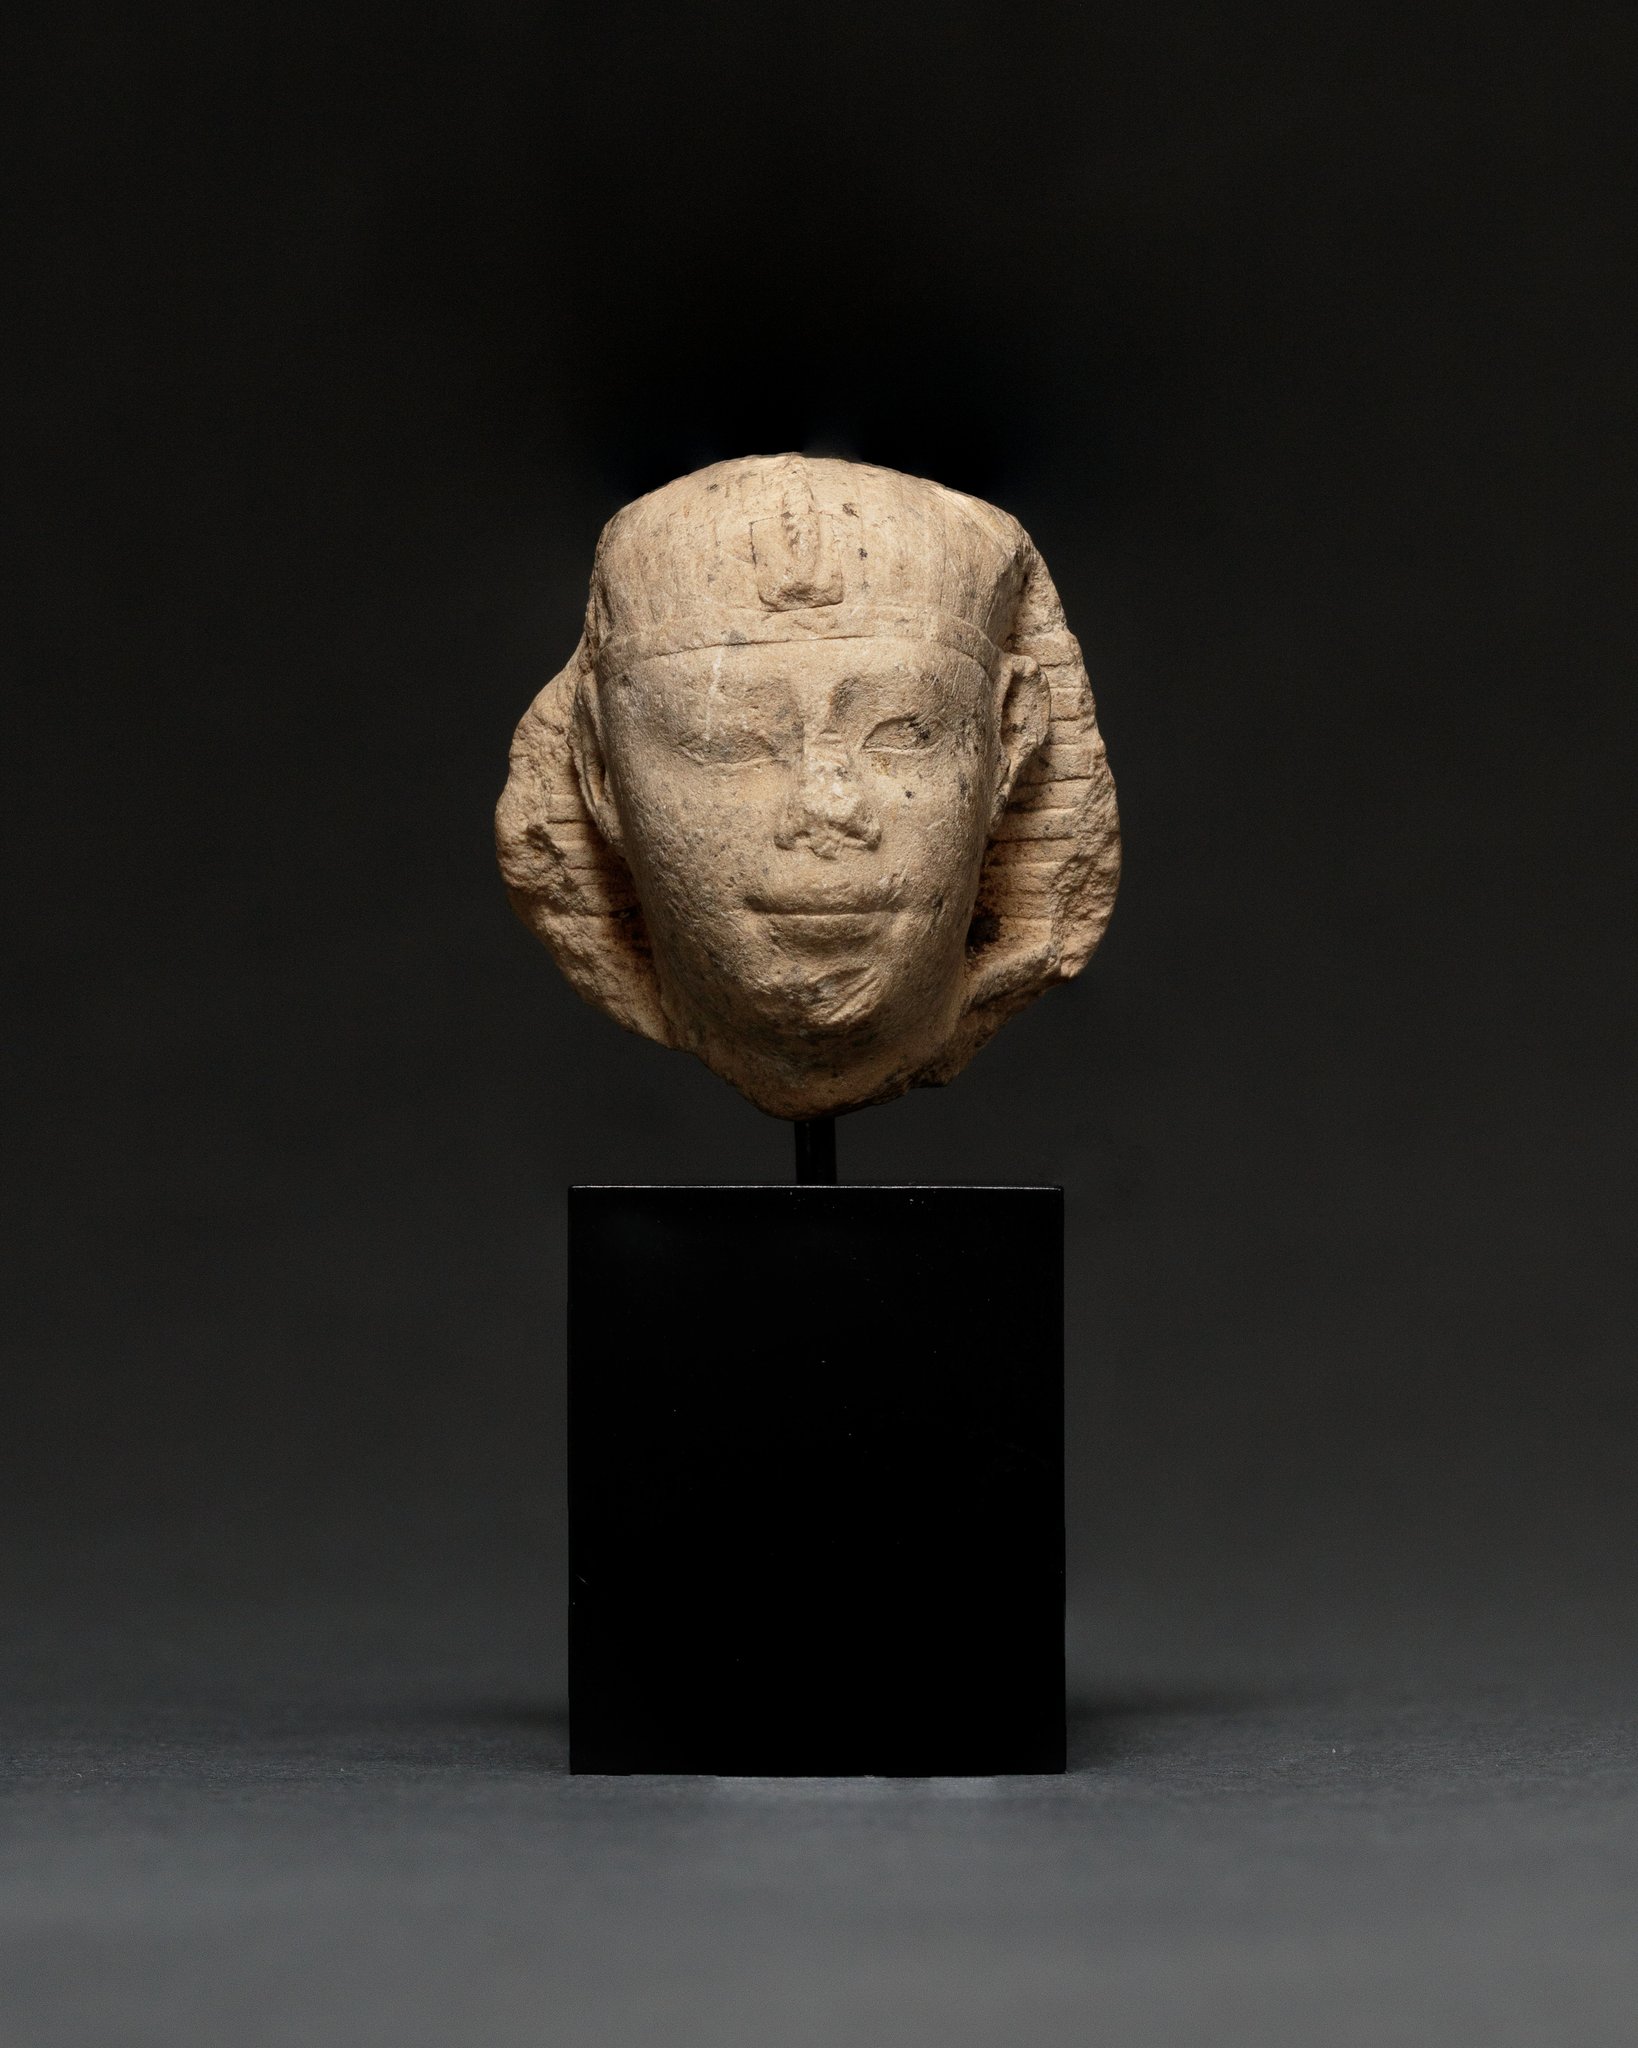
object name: head of a king with a nemes headdress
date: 332-330 BCE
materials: limestone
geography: egypt